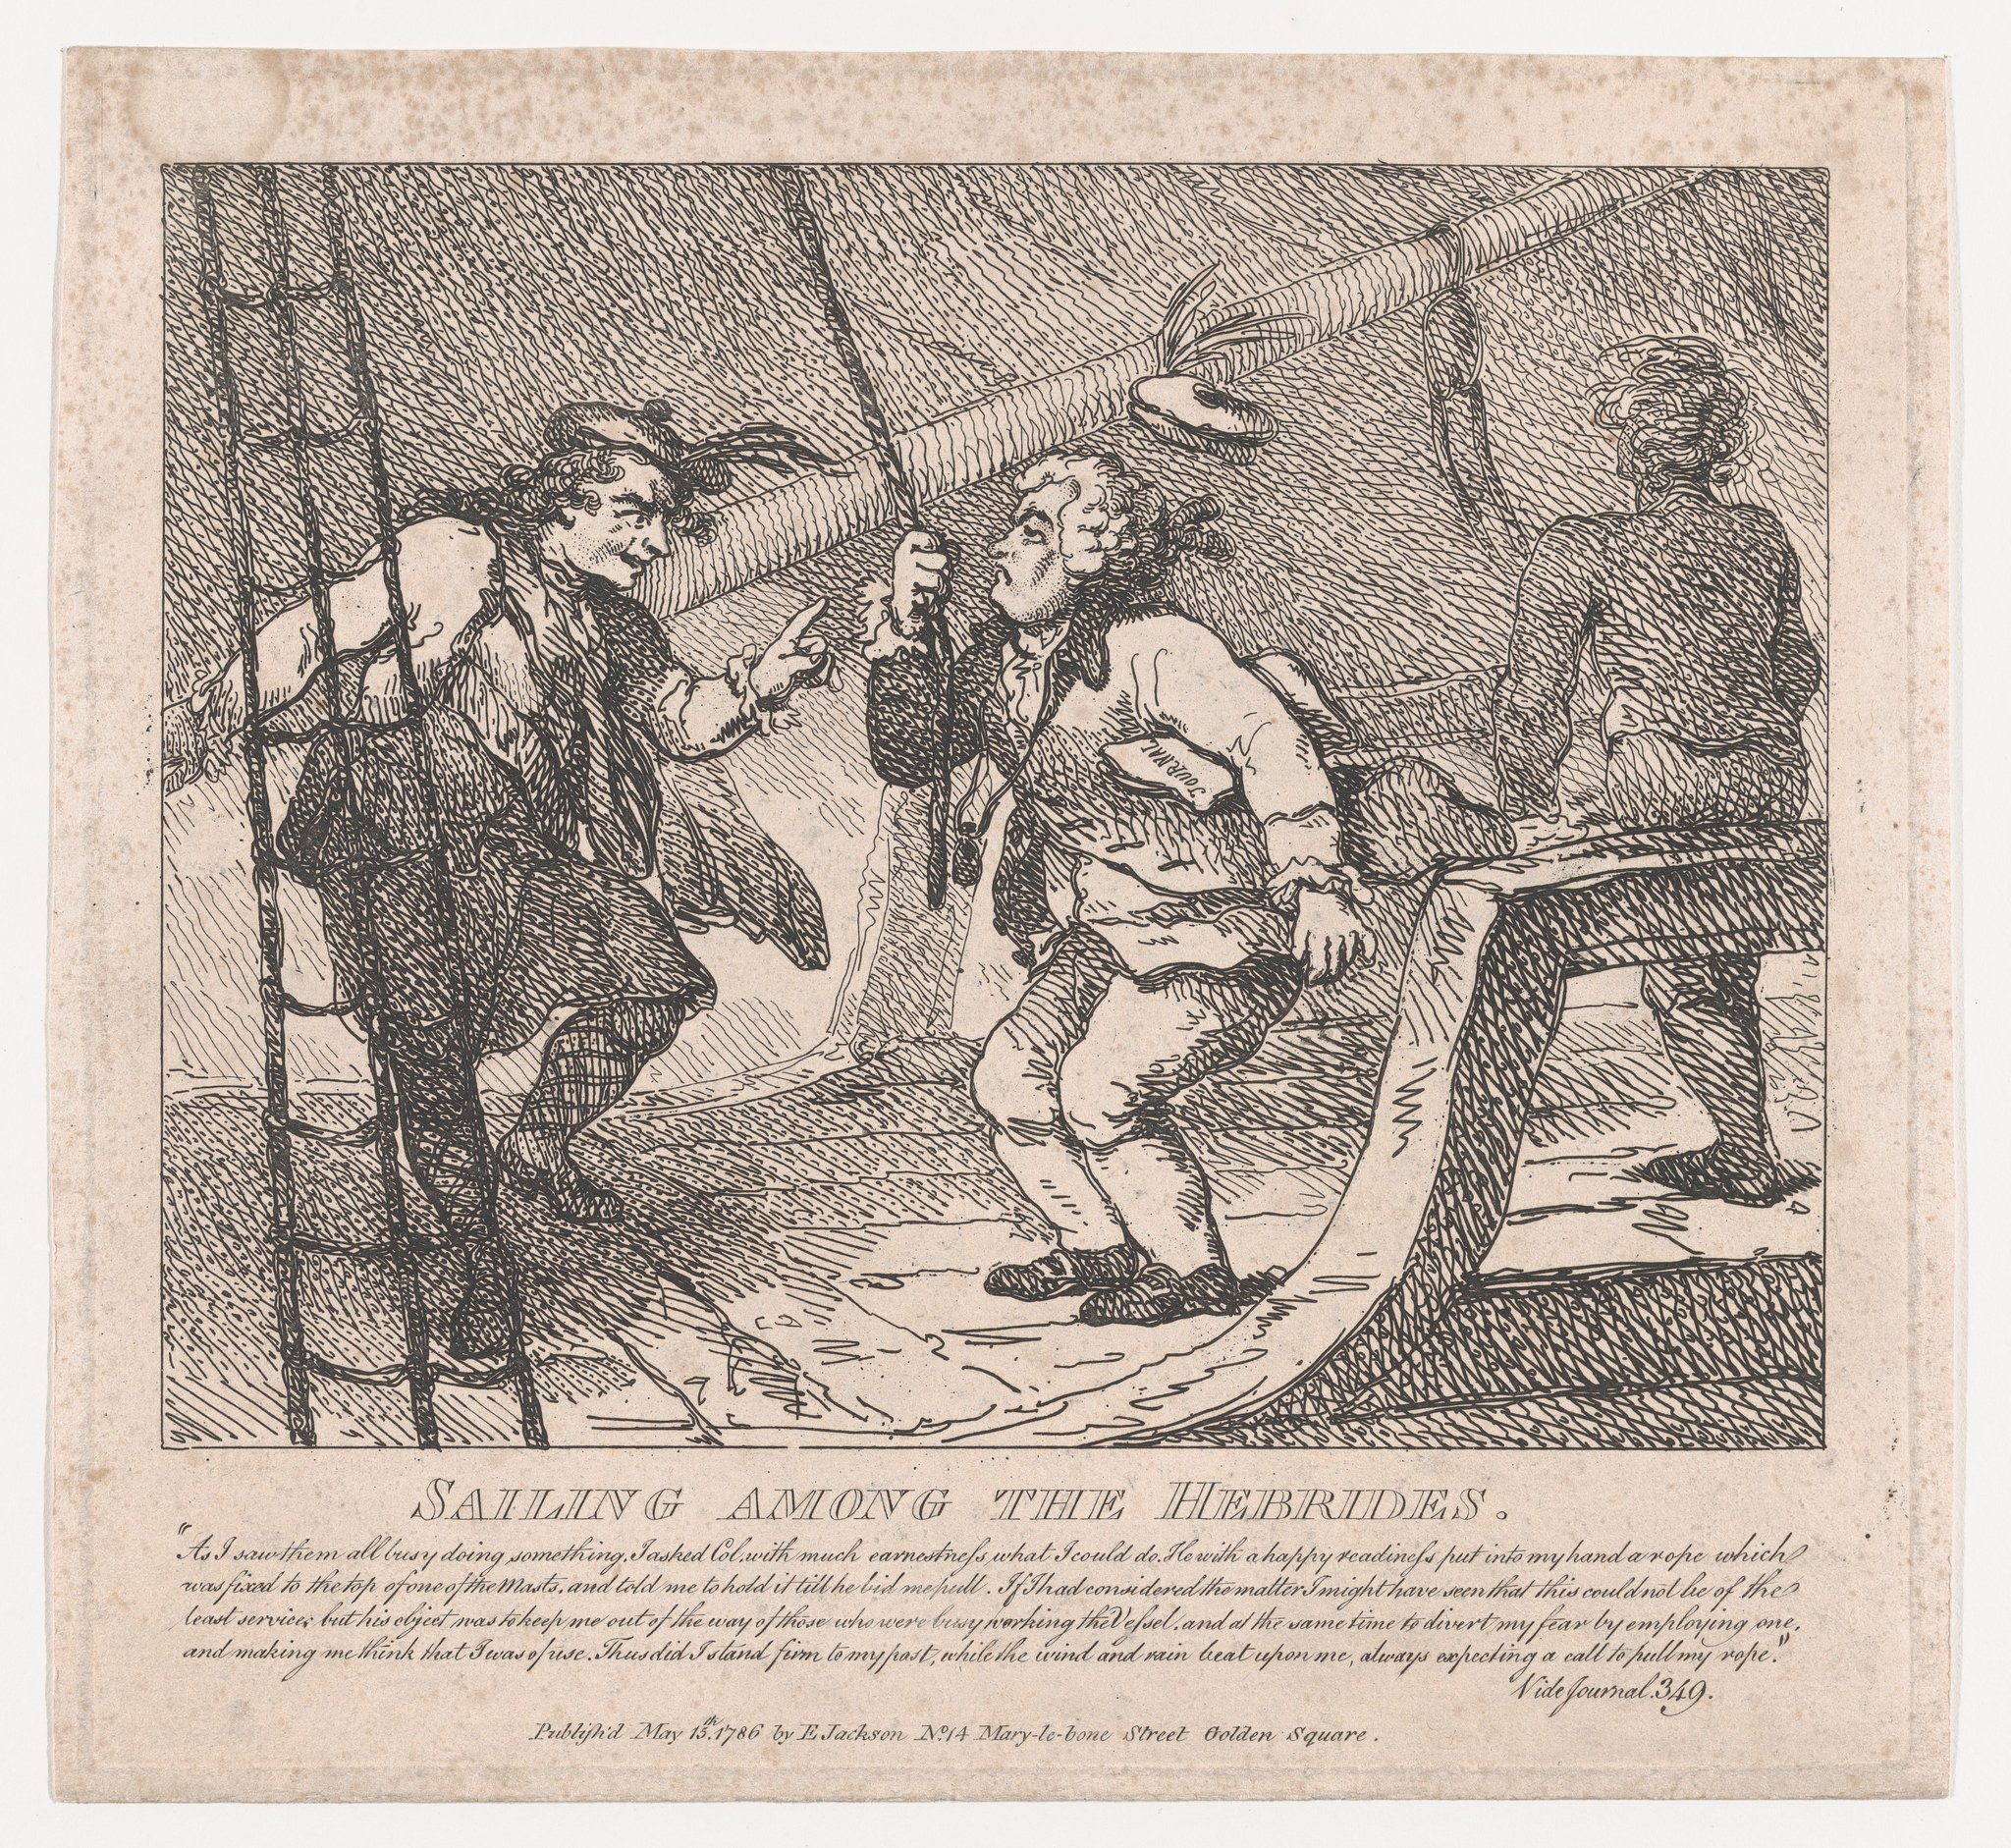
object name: print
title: Sailing Among the Hebrides (Picturesque Beauties of Boswell, Part the Second)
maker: thomas rowlandson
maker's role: artist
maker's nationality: british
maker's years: 1757-1827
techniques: etching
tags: men,profiles,sailing